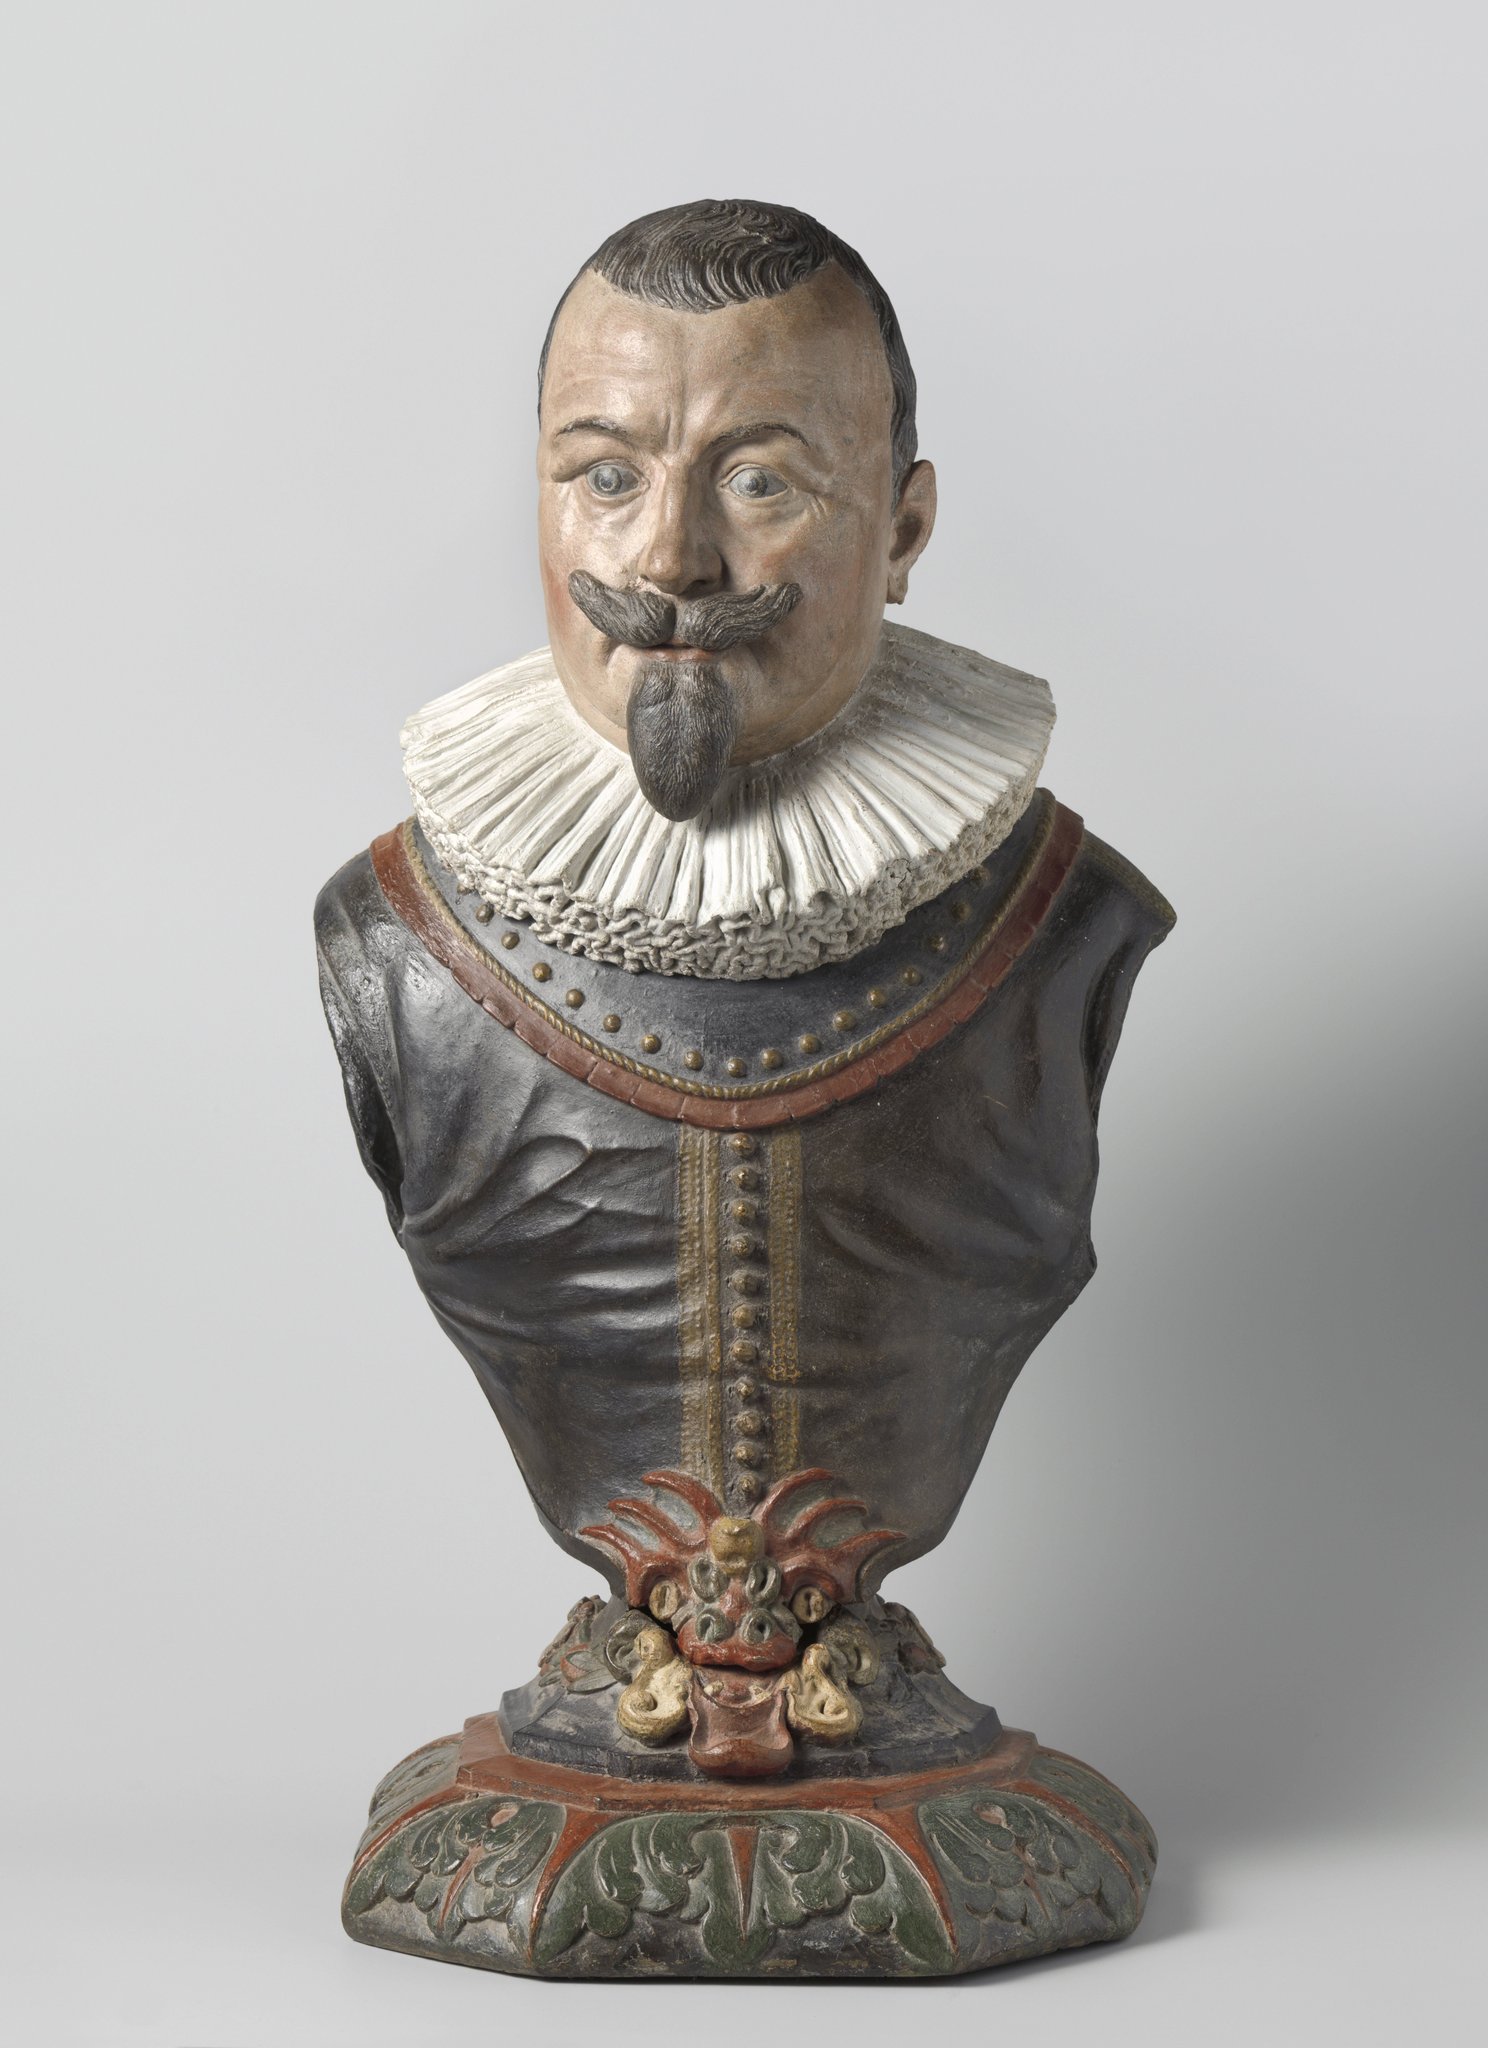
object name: figure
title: Bust of Piet Hein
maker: hendrick de keyser (ii)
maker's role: sculptor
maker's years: 1613-1665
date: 1636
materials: terracotta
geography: amsterdam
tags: delfshaven, historical persons (+ (full) bust portrait)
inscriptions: date, reverse side collar, incised in the wet clay: ‘1636’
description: Piet Hein fought in the Netherlands, the Mediterranean Sea, Asia, Africa, and America as a seaman. But he only becomes truly famous when he captures the Spanish Silver Fleet off the coast of Cuba in September 1628. For the Spanish the loss of that fleet is a financial catastrophe and for the Dutch Republic, quite the opposite, a tremendous triumph. Hein becomes enormously popular among the Dutch and is honoured everywhere. Just a year later, Hein dies in a skirmish with privateers from Ostend in the English Channel.